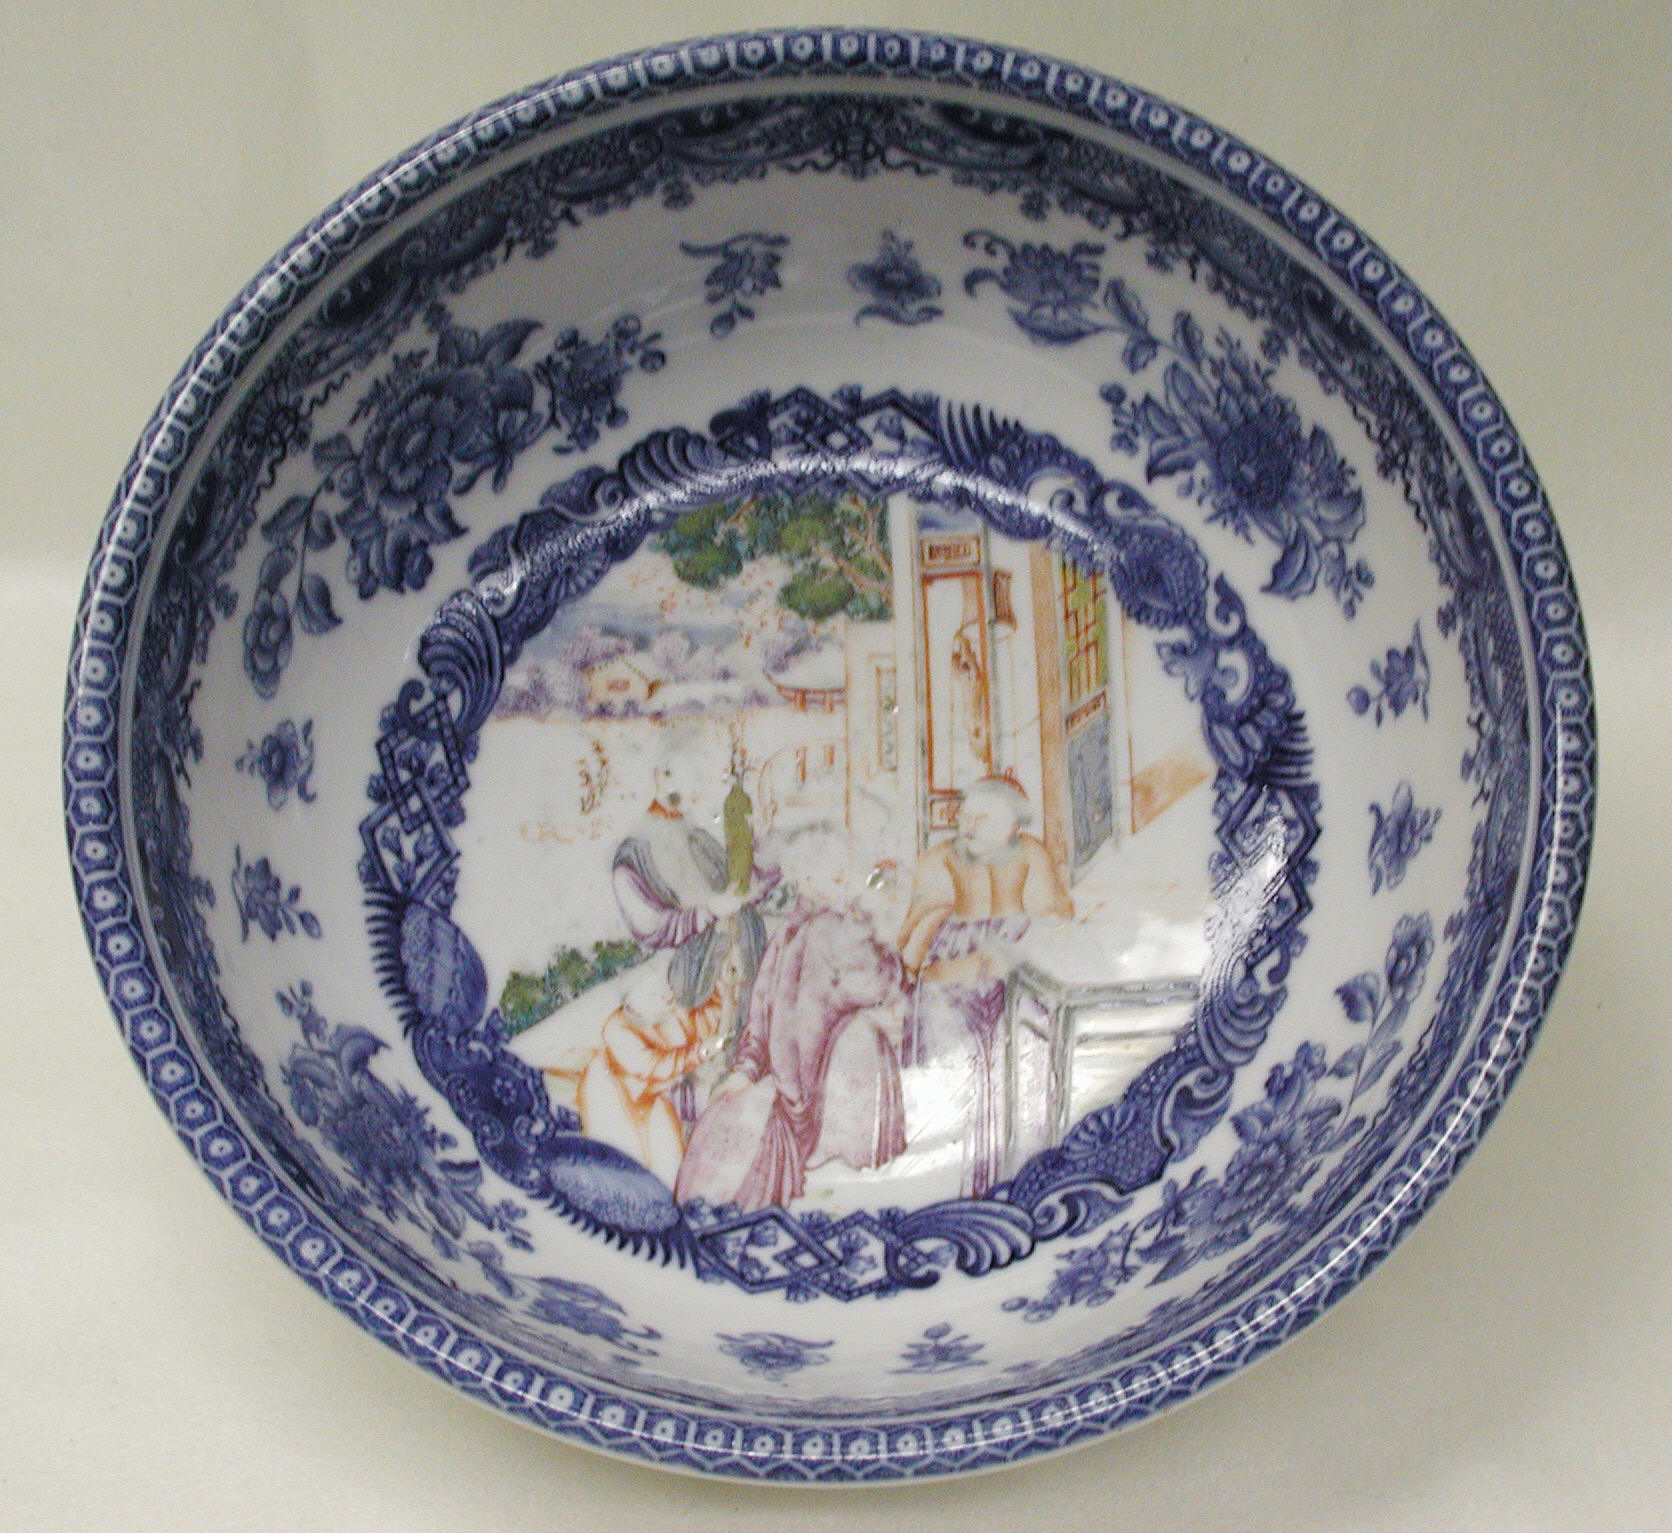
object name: basin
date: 1765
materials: hard paste porcelain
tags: men,women